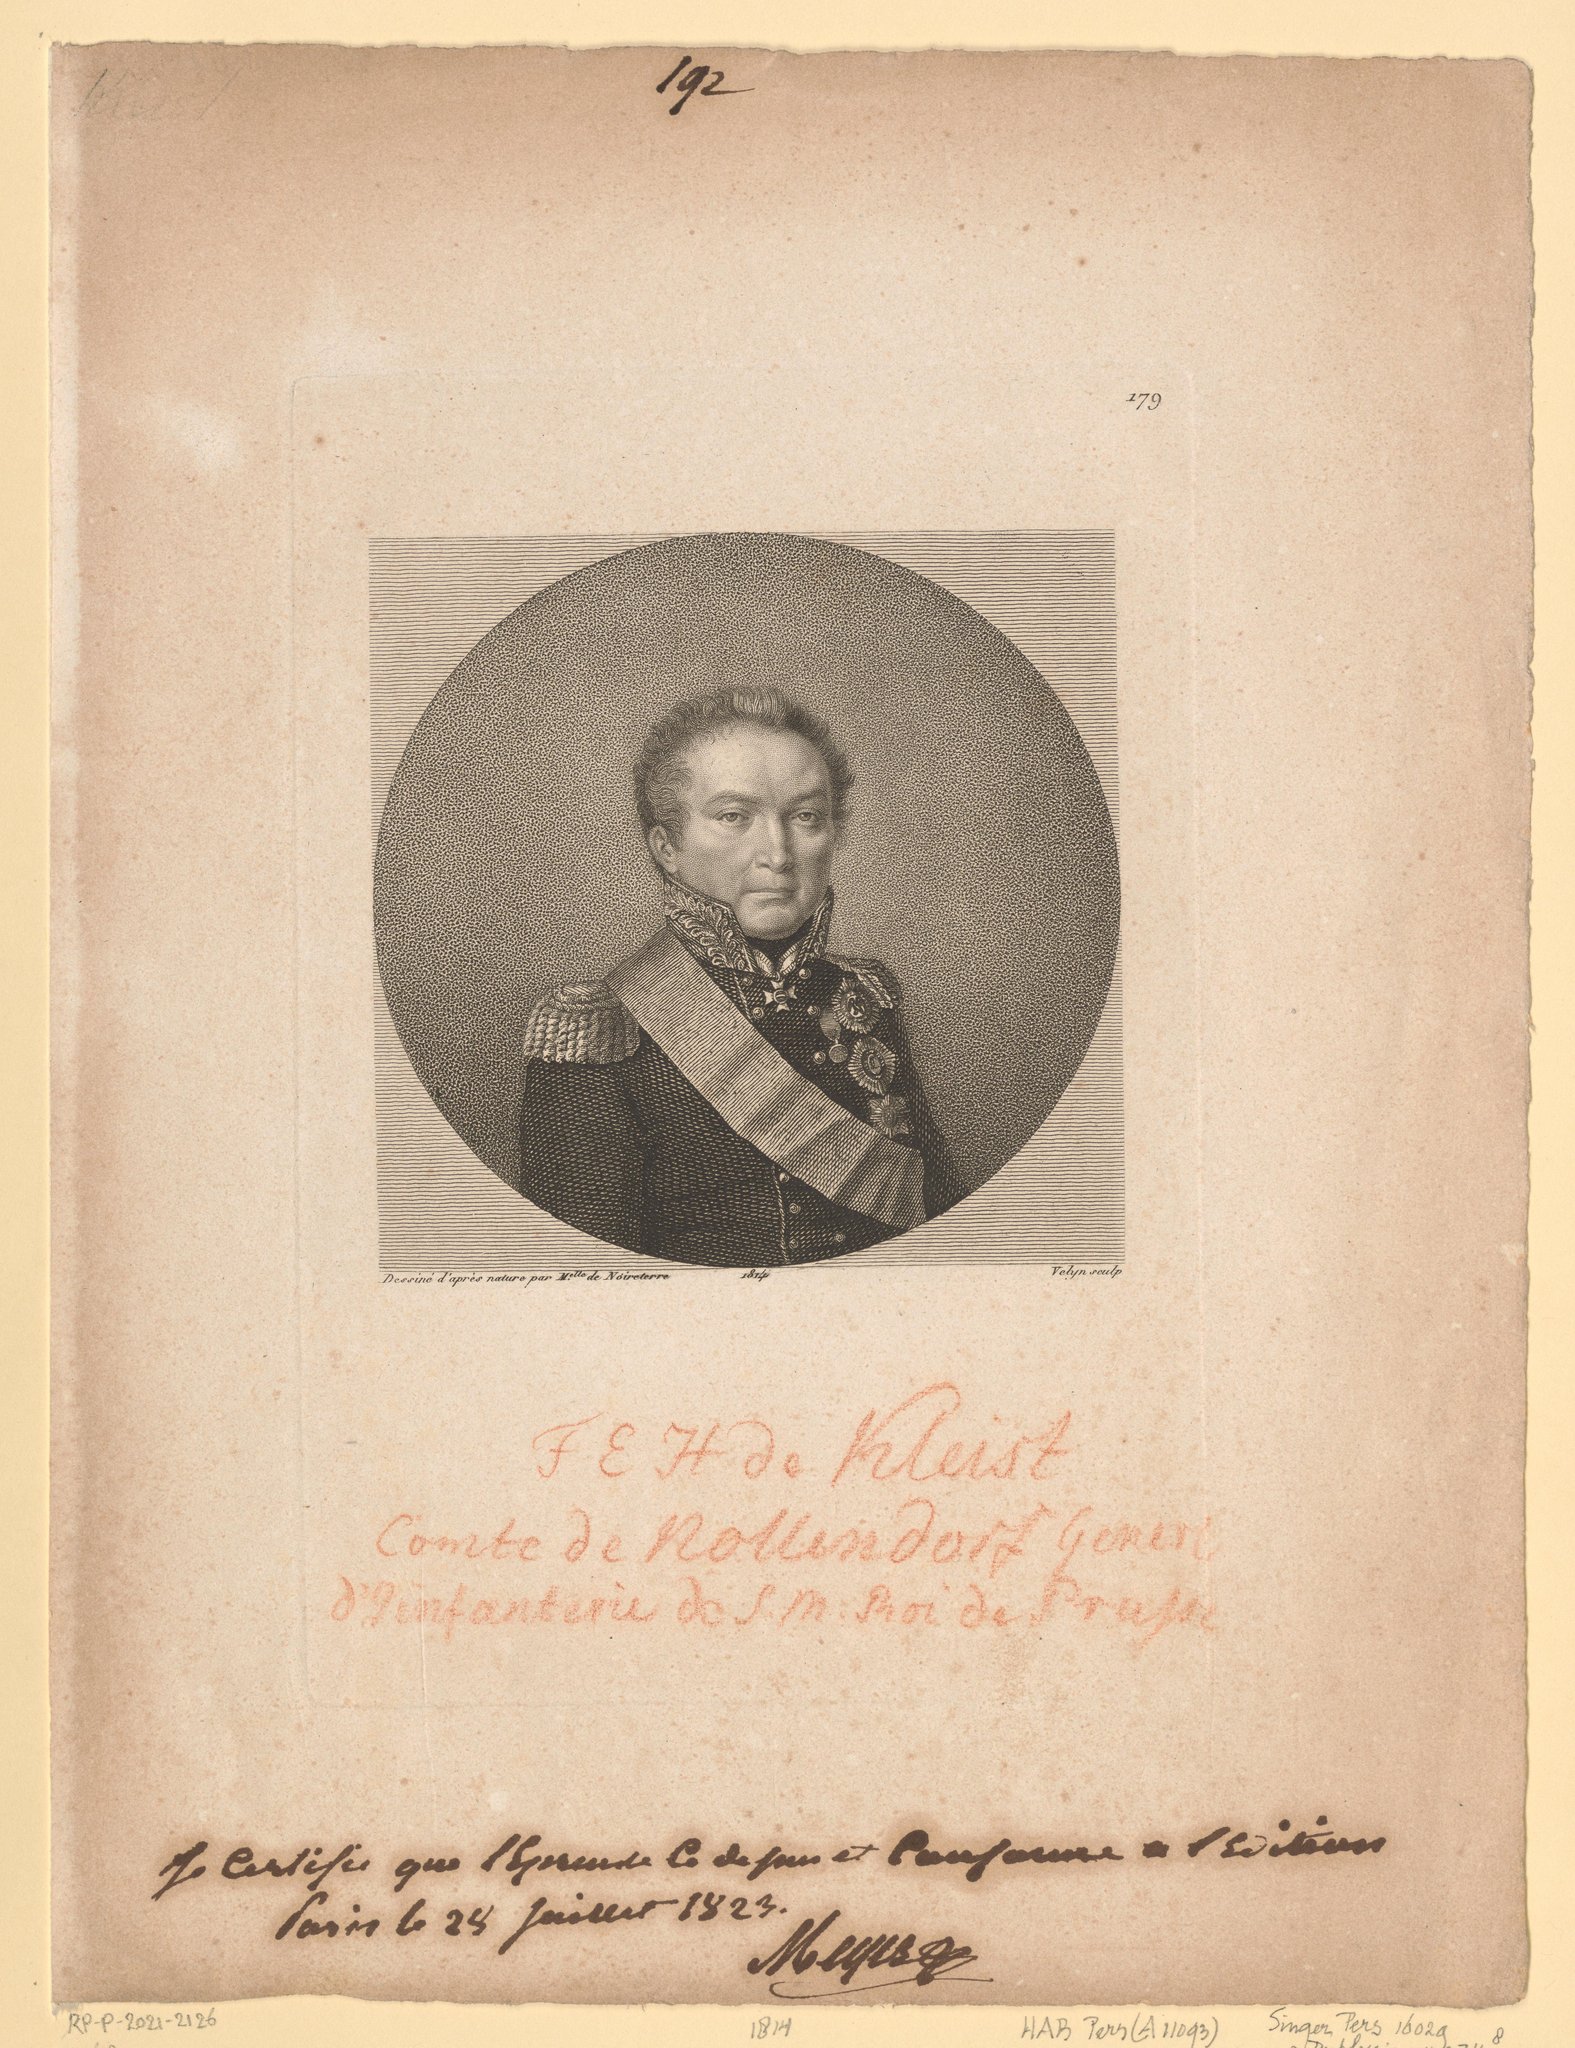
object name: print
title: Portret van graaf Friedrich von Kleist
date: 1814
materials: paper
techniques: etching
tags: berlin, historical persons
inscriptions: date